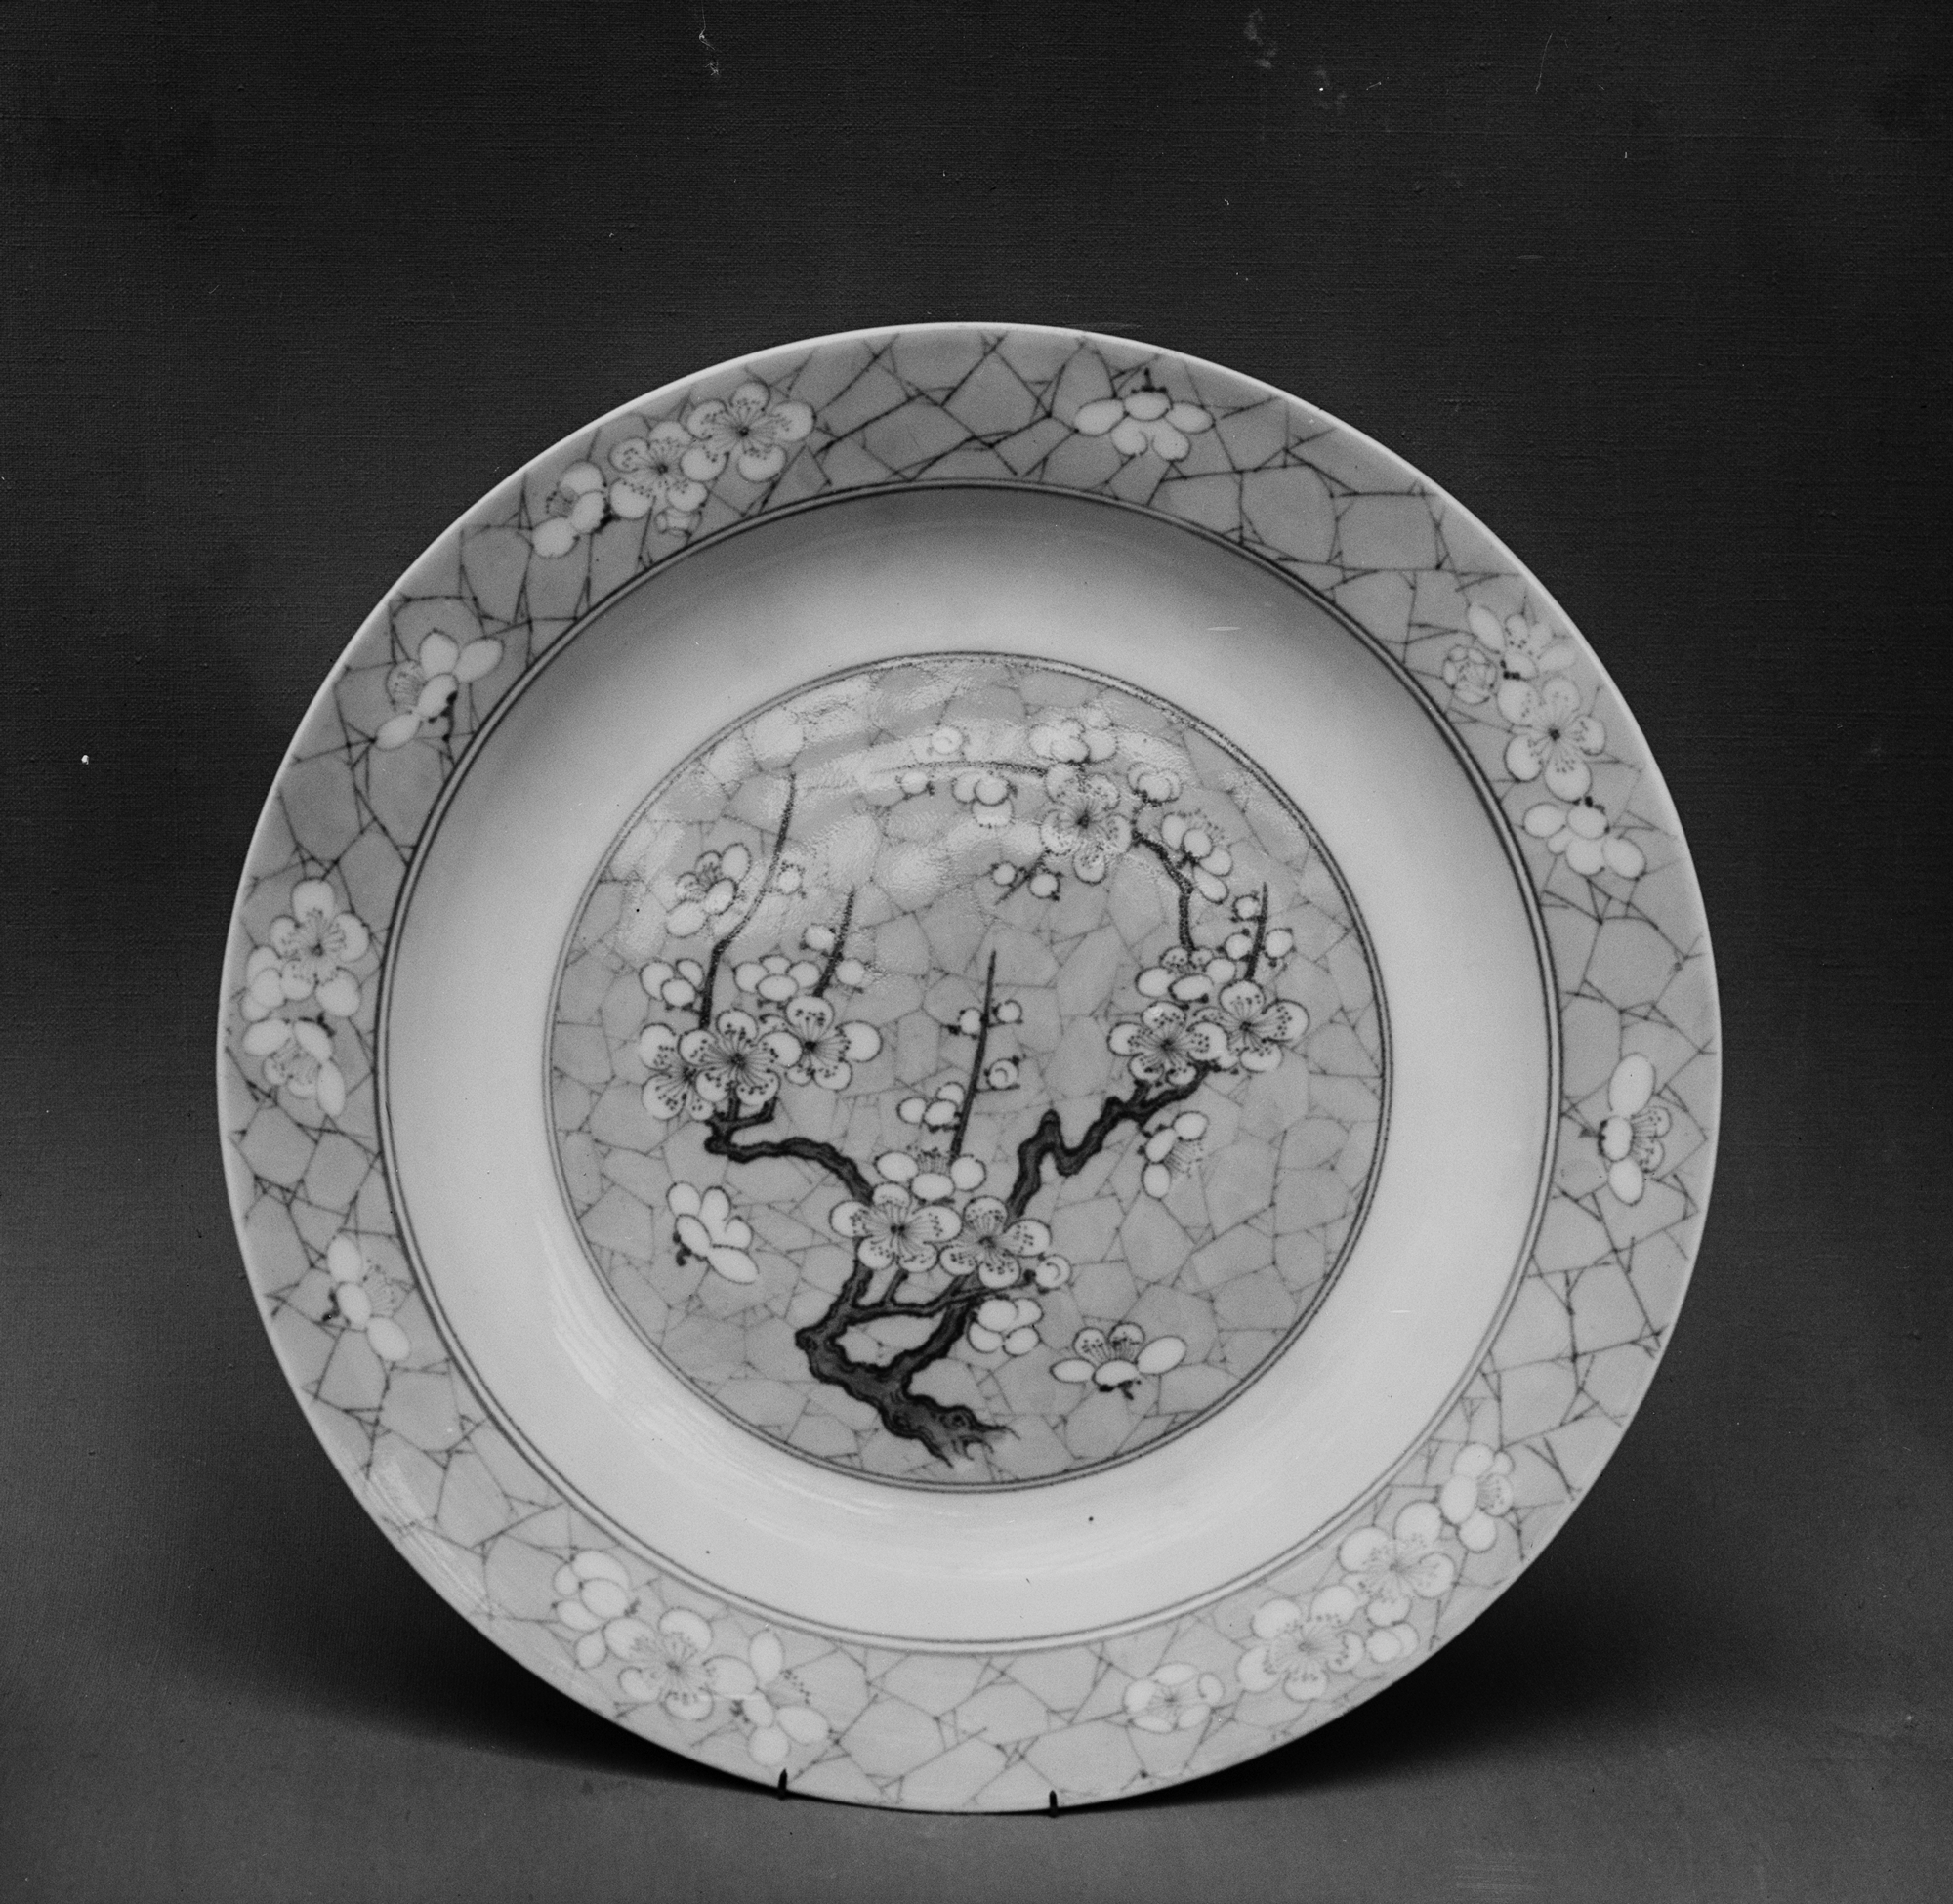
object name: plate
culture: japanese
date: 1780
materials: glaze, porcelain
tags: flowers